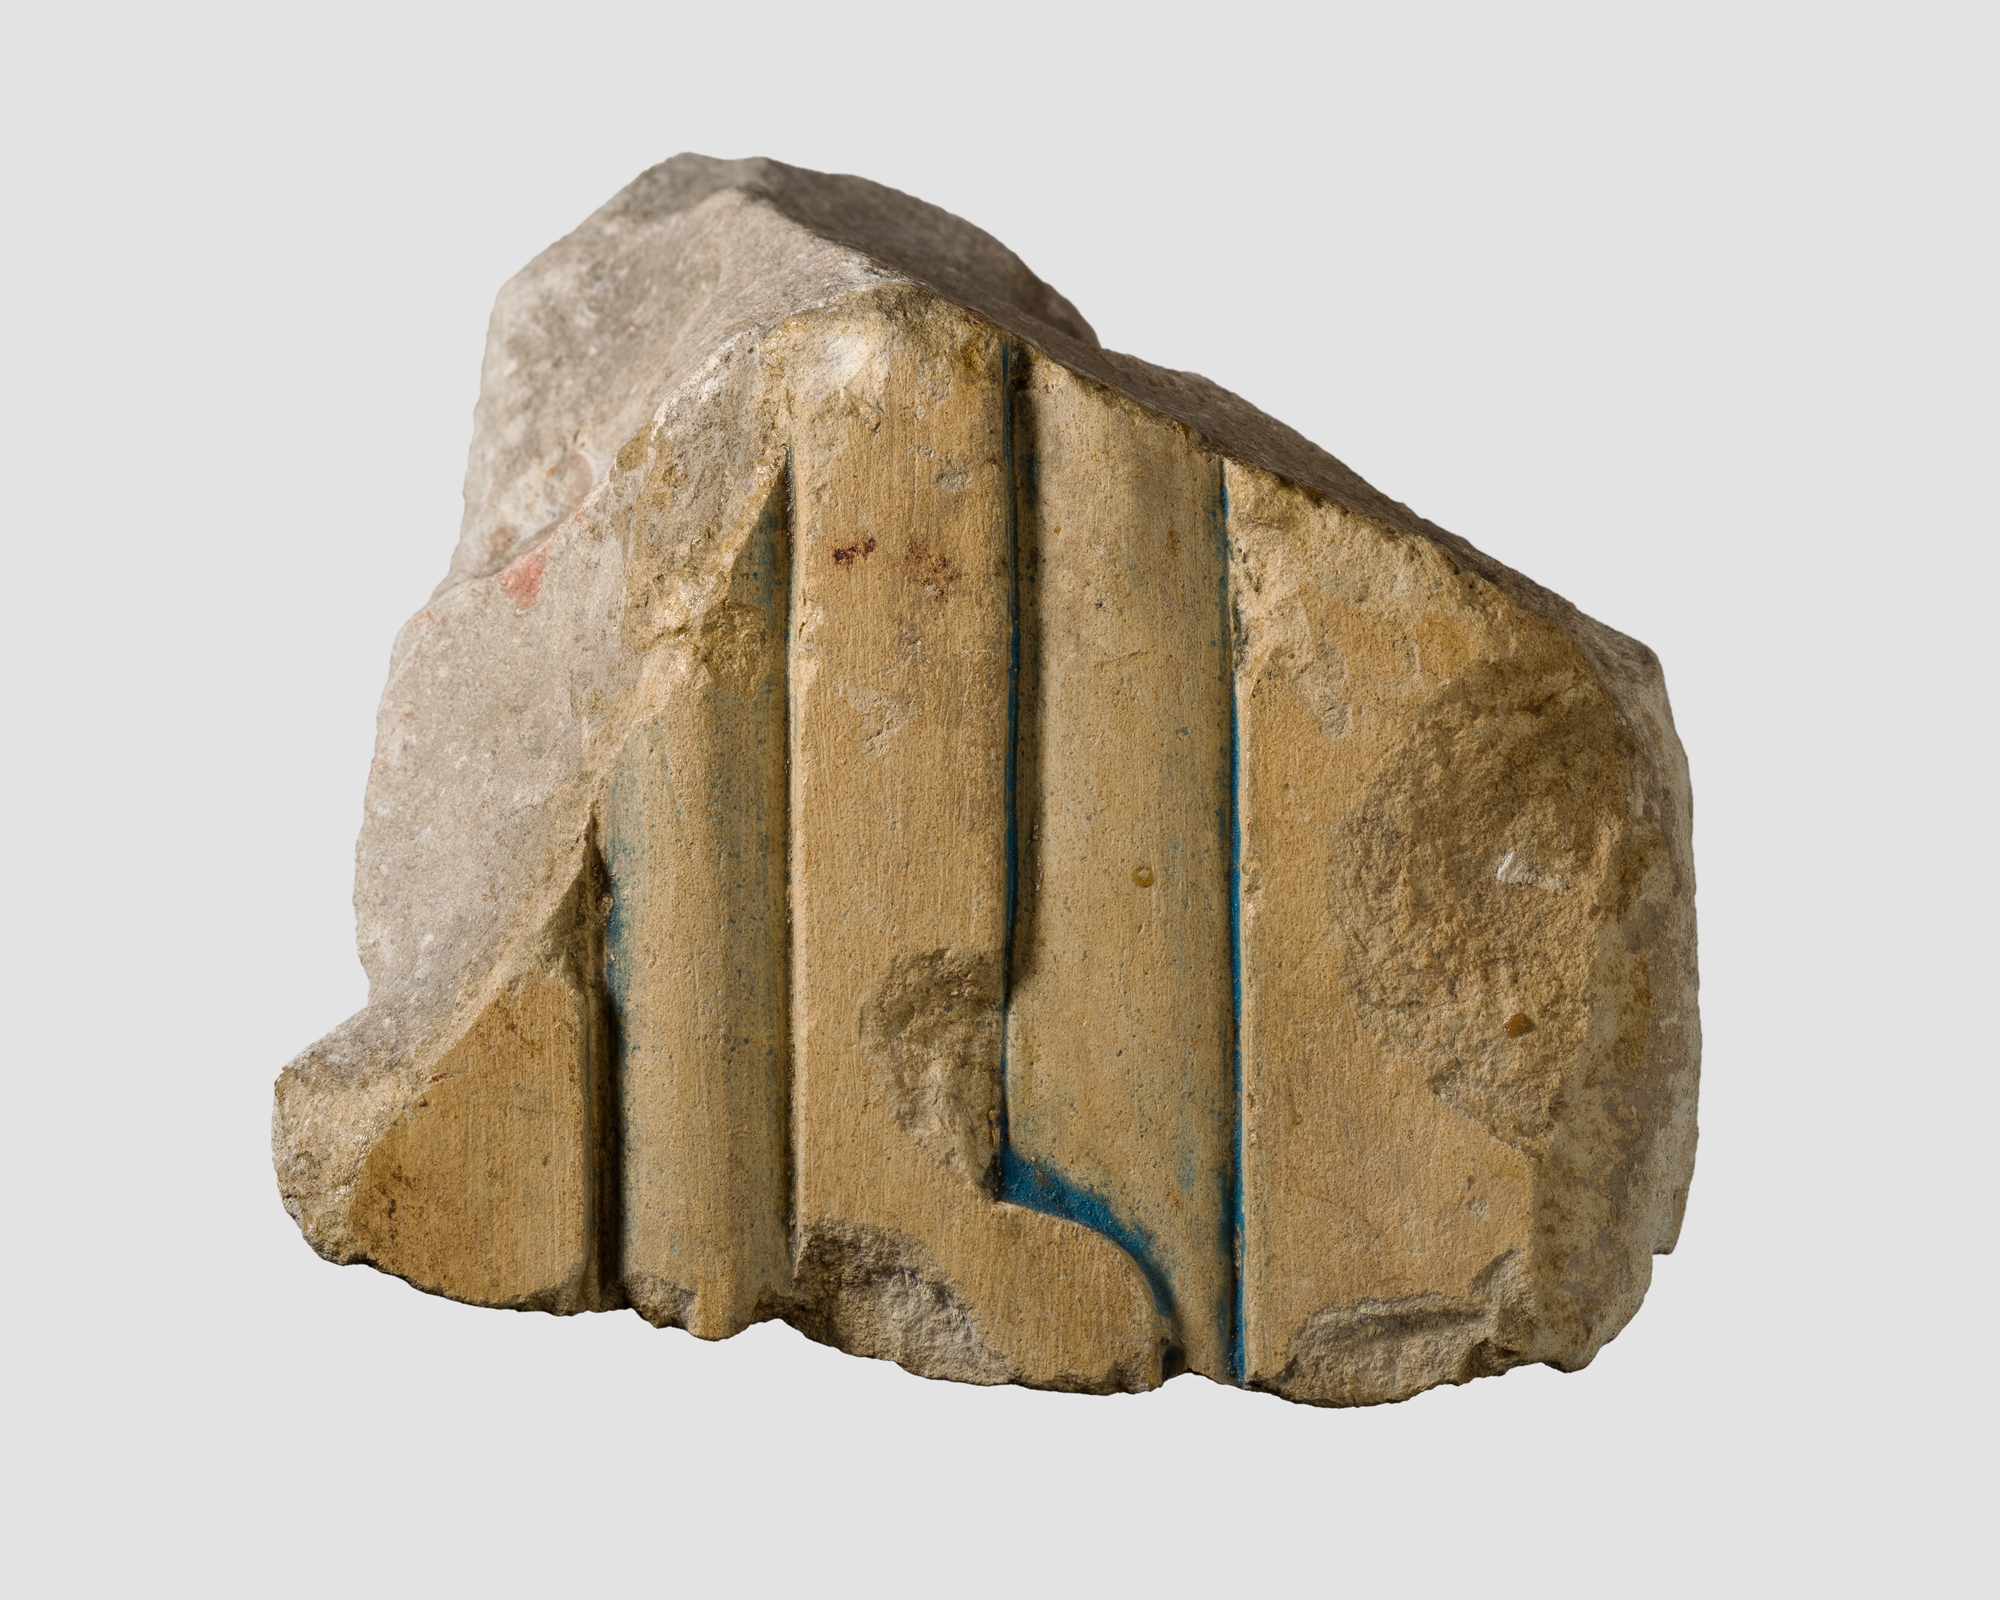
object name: relief fragment, neferu or khety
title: Relief Fragment from the Tomb of Neferu or Khety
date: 2030-1640 BCE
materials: limestone, paint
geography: egypt